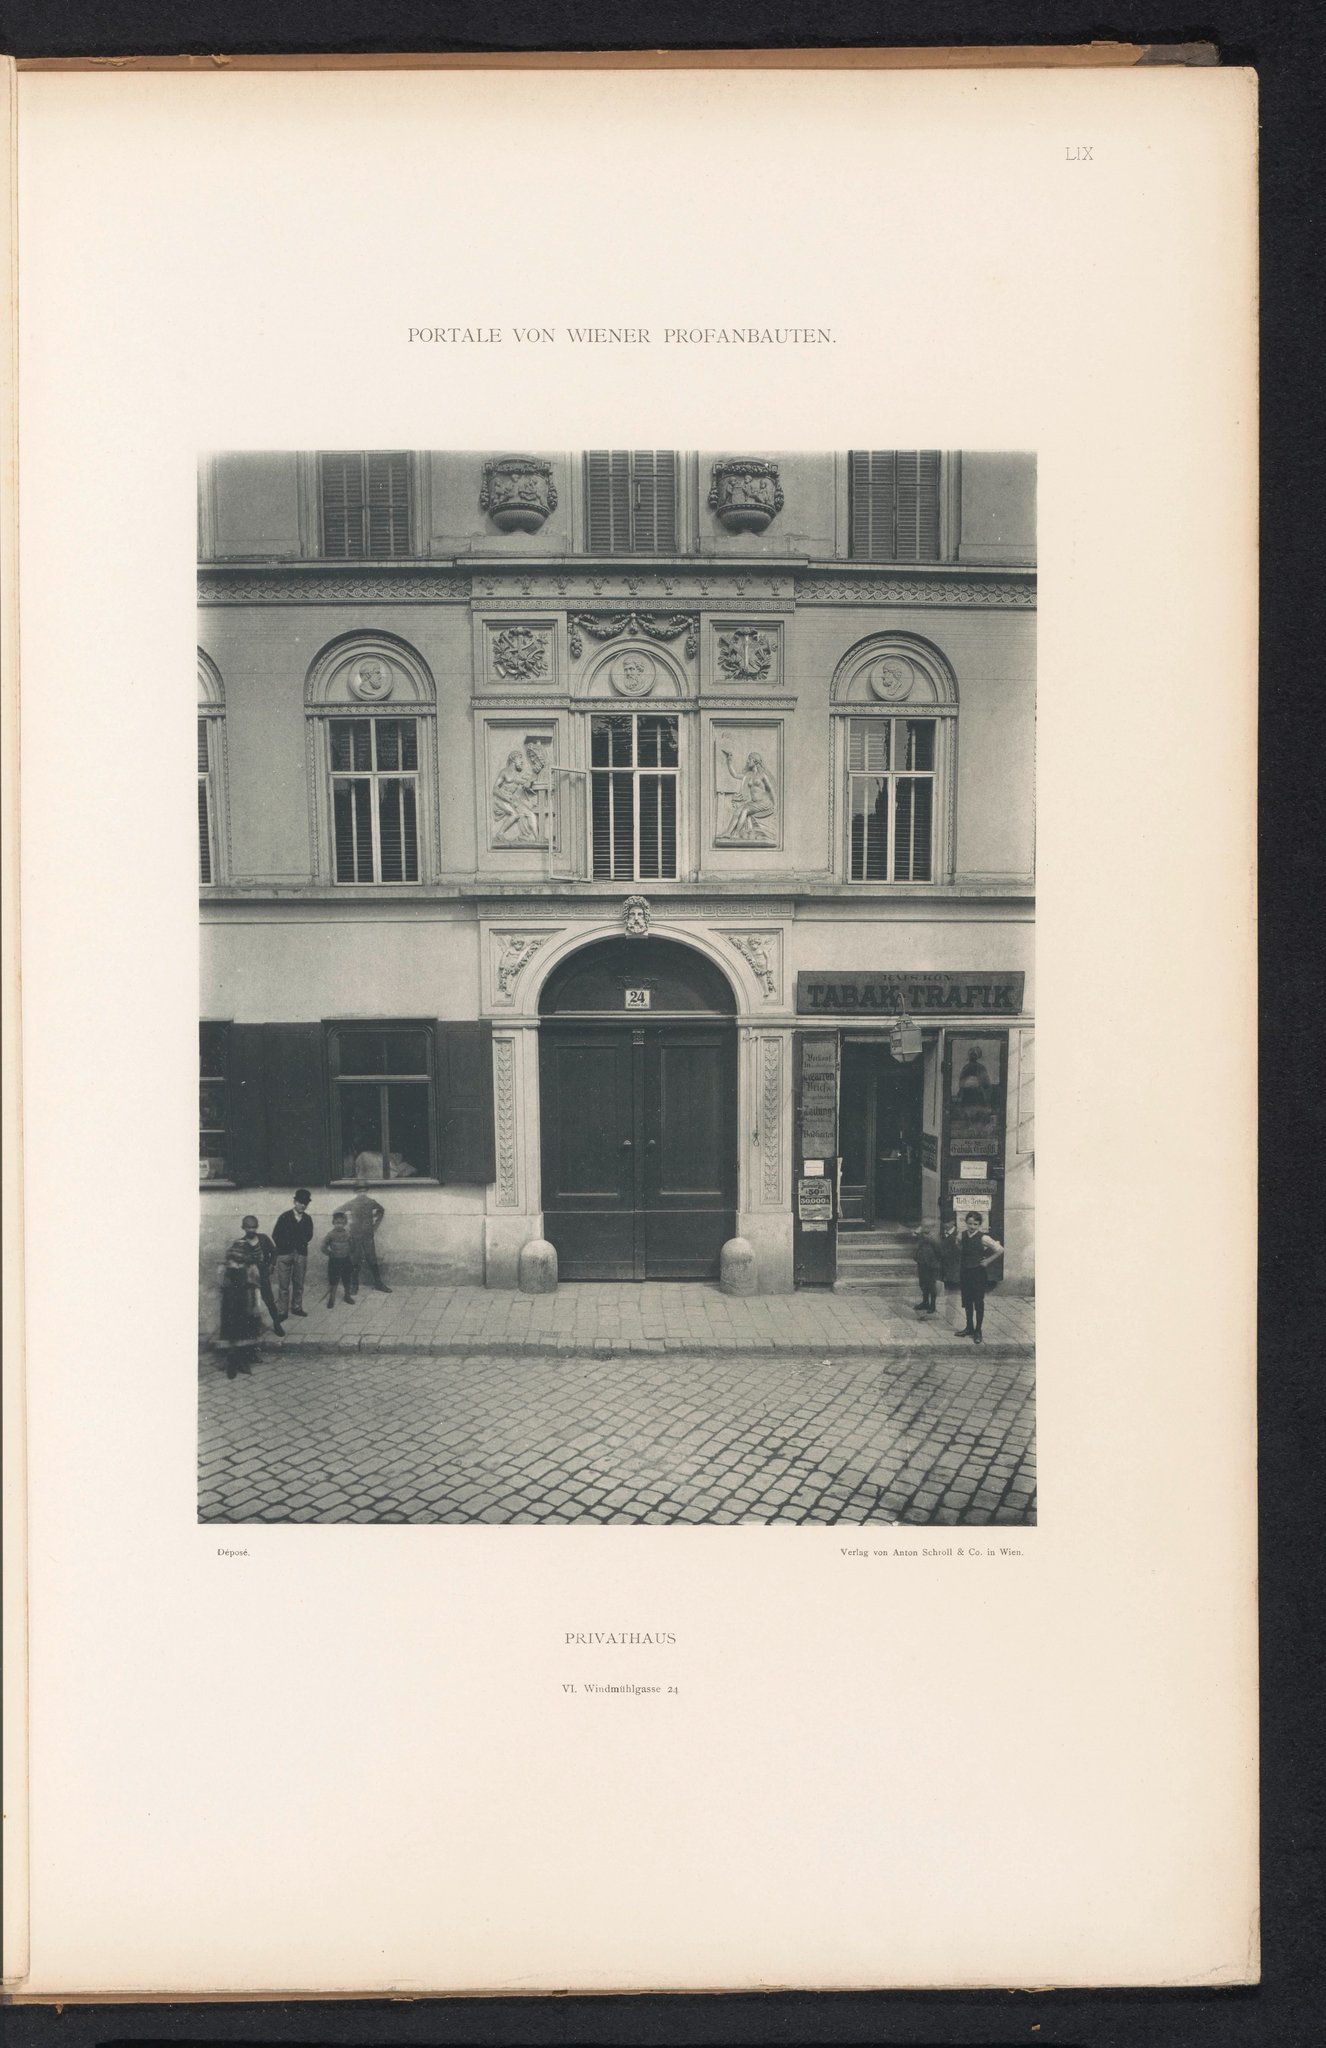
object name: page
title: Toegangsportaal van een woning aan Windmühlgasse 24 te Wenen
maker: Anonymous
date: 1884-1894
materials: paper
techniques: photograph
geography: austria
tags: gate, entrance, façade (of house or building)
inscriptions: inscription: ‘VI. Windmühlgasse 24’, number: ‘LIX’